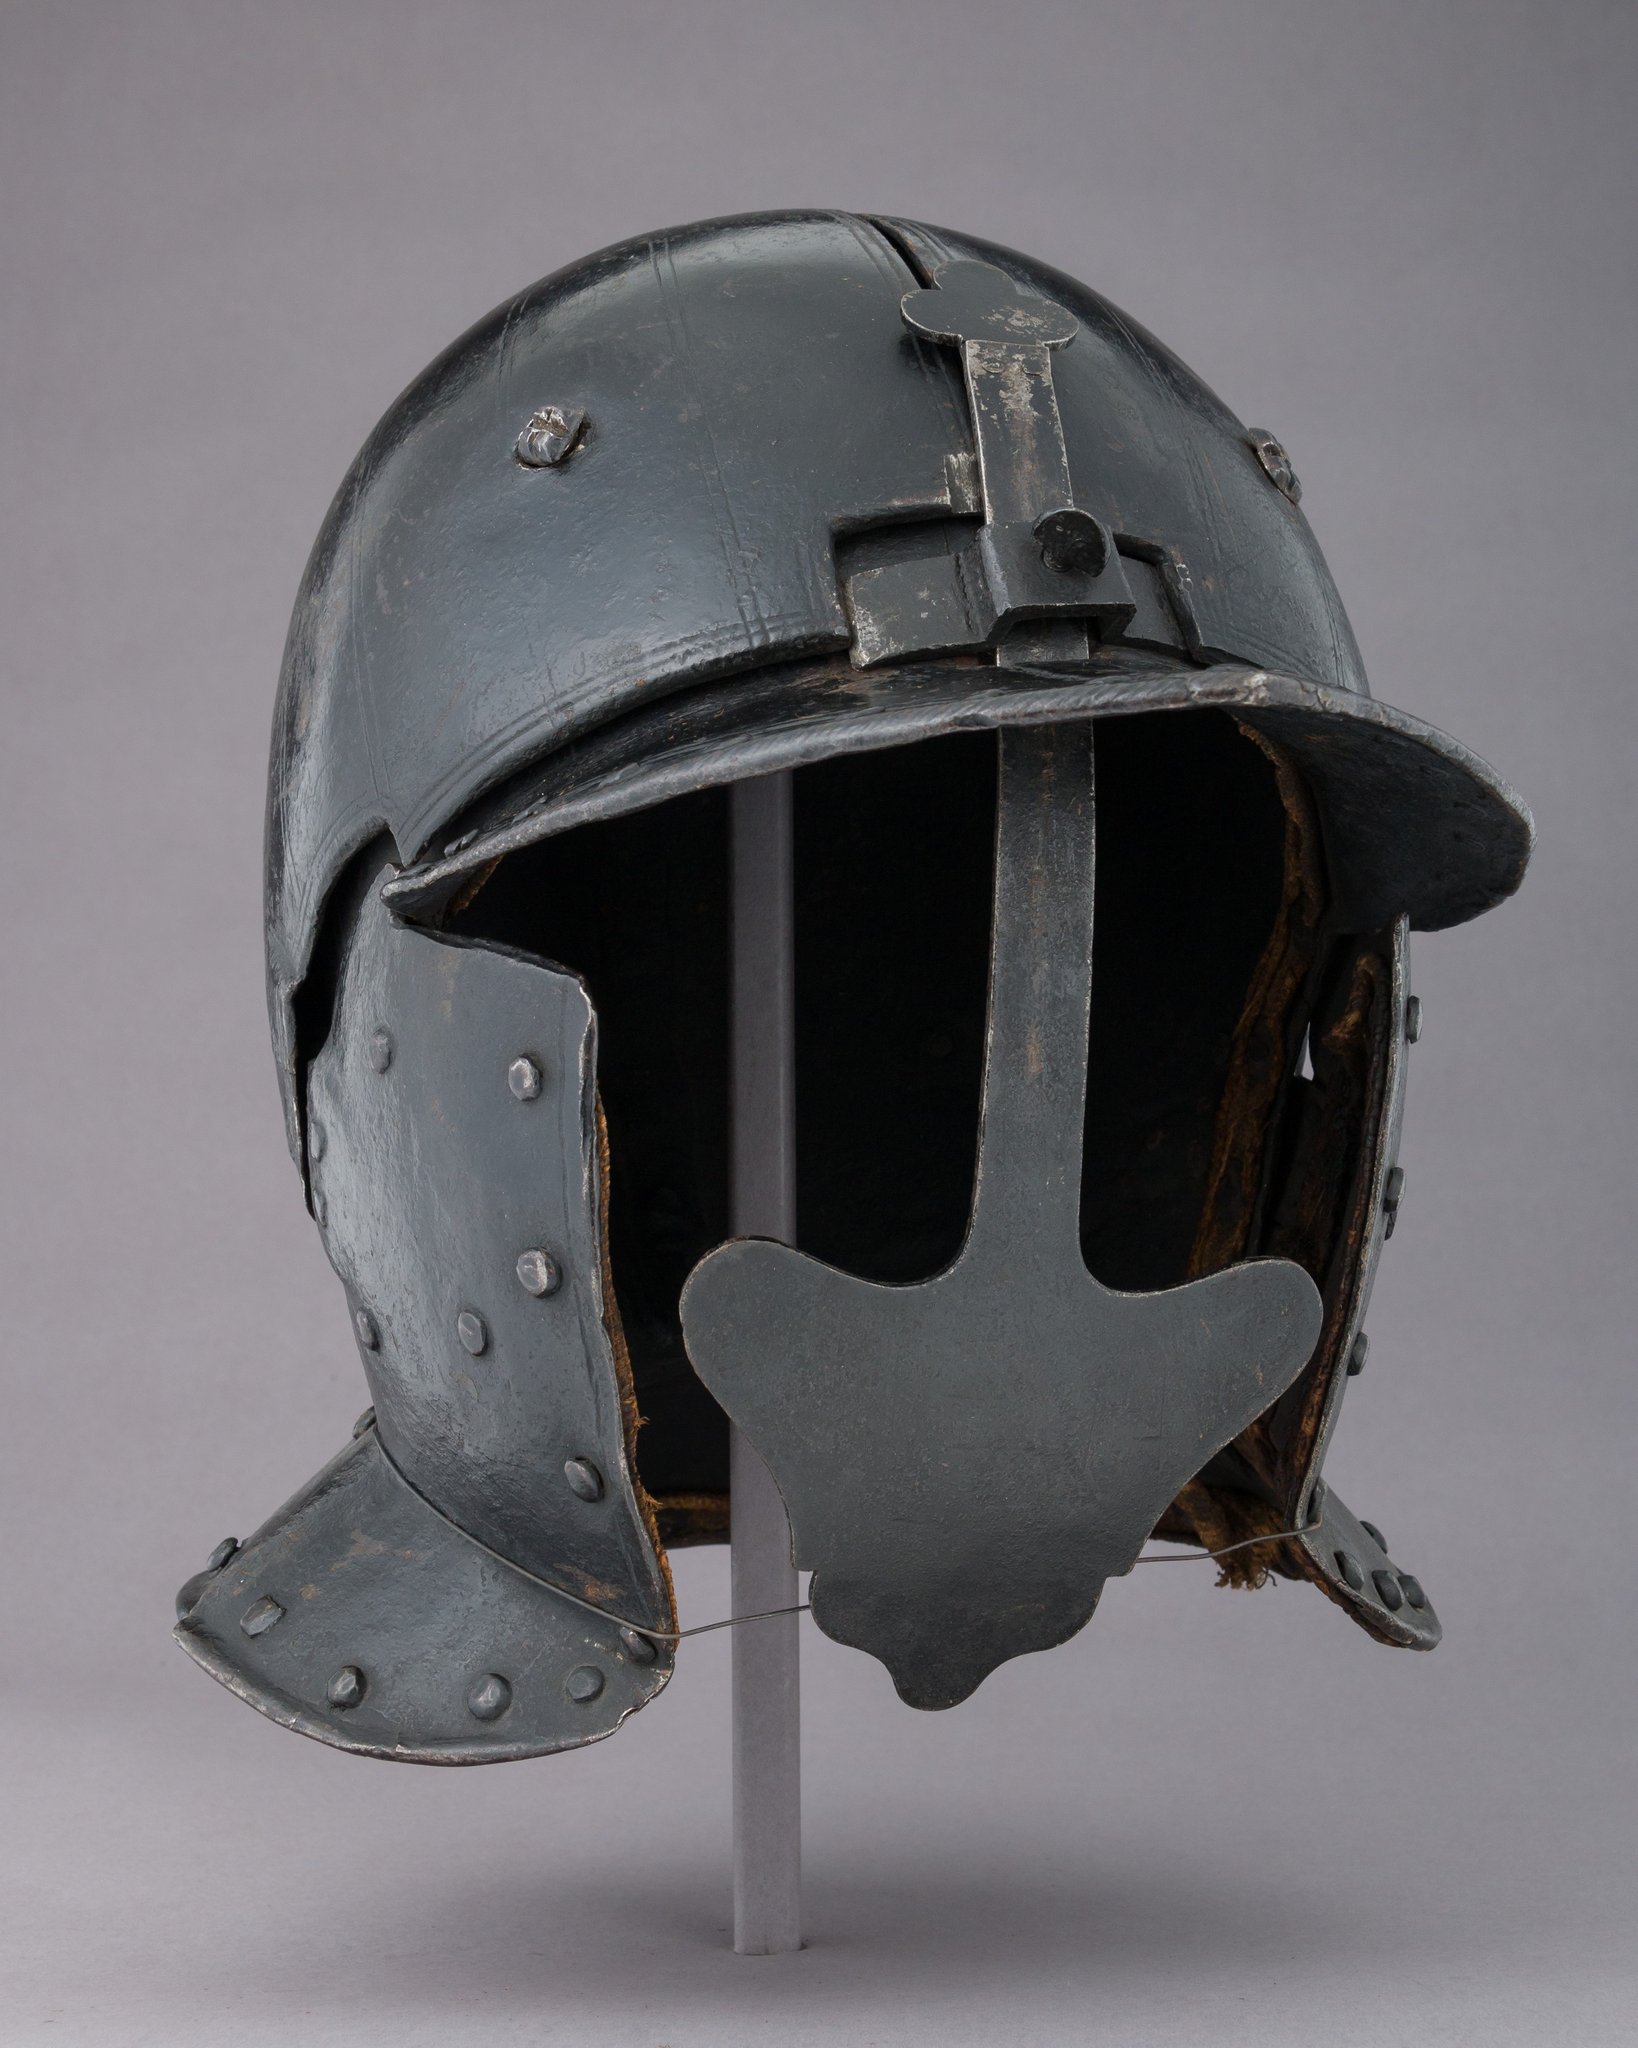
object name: siege helmet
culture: french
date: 1601-1700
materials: leather, steel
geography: france